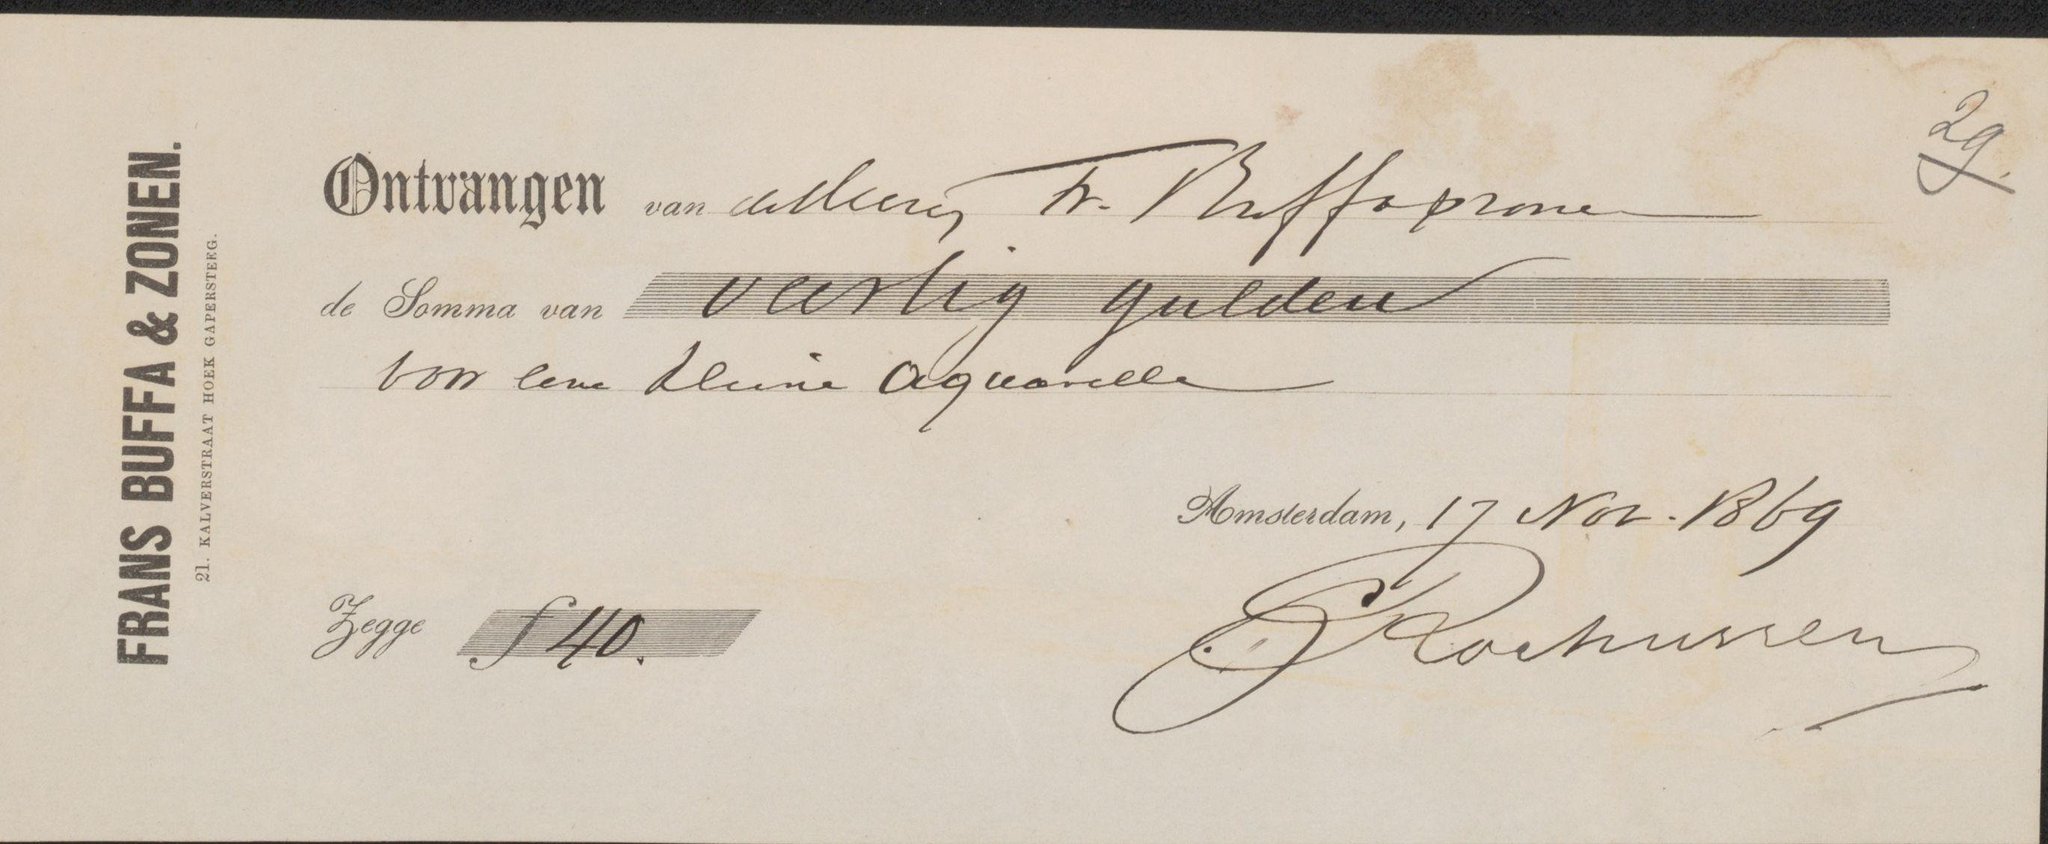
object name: ontvangstbewijs, kwitantie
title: Kwitantie voor Charles Rochussen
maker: charles rochussen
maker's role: draughtsman, painter, print maker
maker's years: 1814-1894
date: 1869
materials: ink, paper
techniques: pen, printing, writing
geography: amsterdam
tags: drawing, money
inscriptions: collector's mark: Lugt 2233